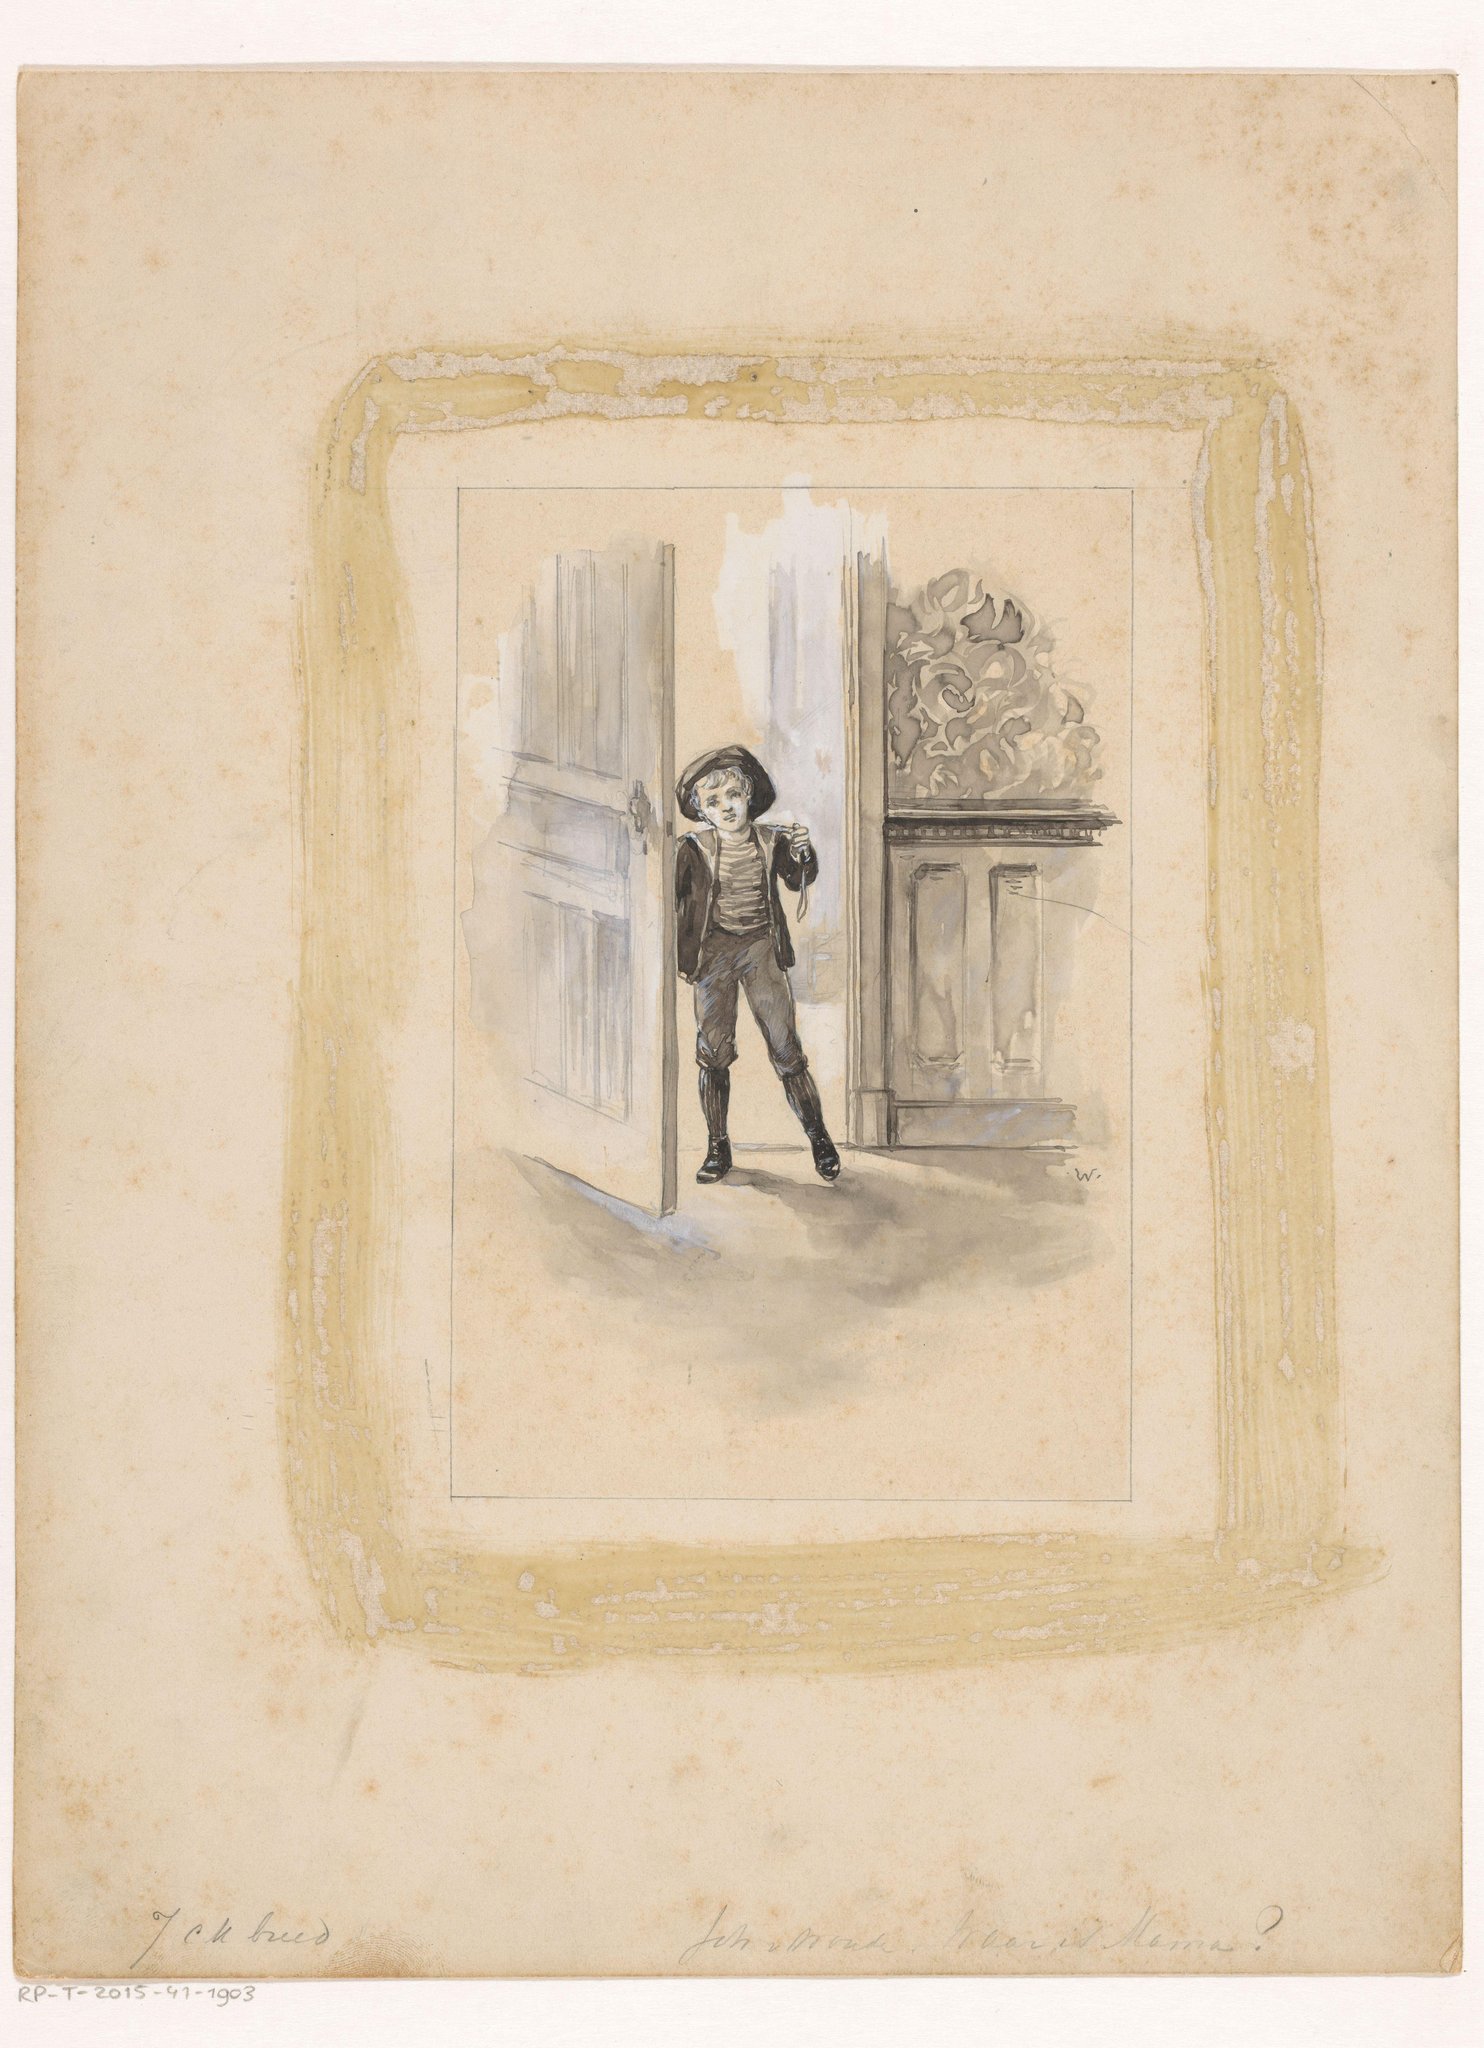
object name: boekillustratie ontwerp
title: Jongen in een deuropening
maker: willem wenckebach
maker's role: designer, draughtsman, painter, print maker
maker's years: 1860-1937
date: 1870-1937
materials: cardboard, paint, pencil, watercolor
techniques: brush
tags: open door, boy (child between toddler and youth)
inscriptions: :, collector's mark: Lugt 2228, annotation: ‘Joh v. Woude, Waar is Mama?’, monogram: ‘.W.’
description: Een jongen met een hoed staat in een deuropening. Hij heeft een voorwerp met een touw in zijn linkerhand.